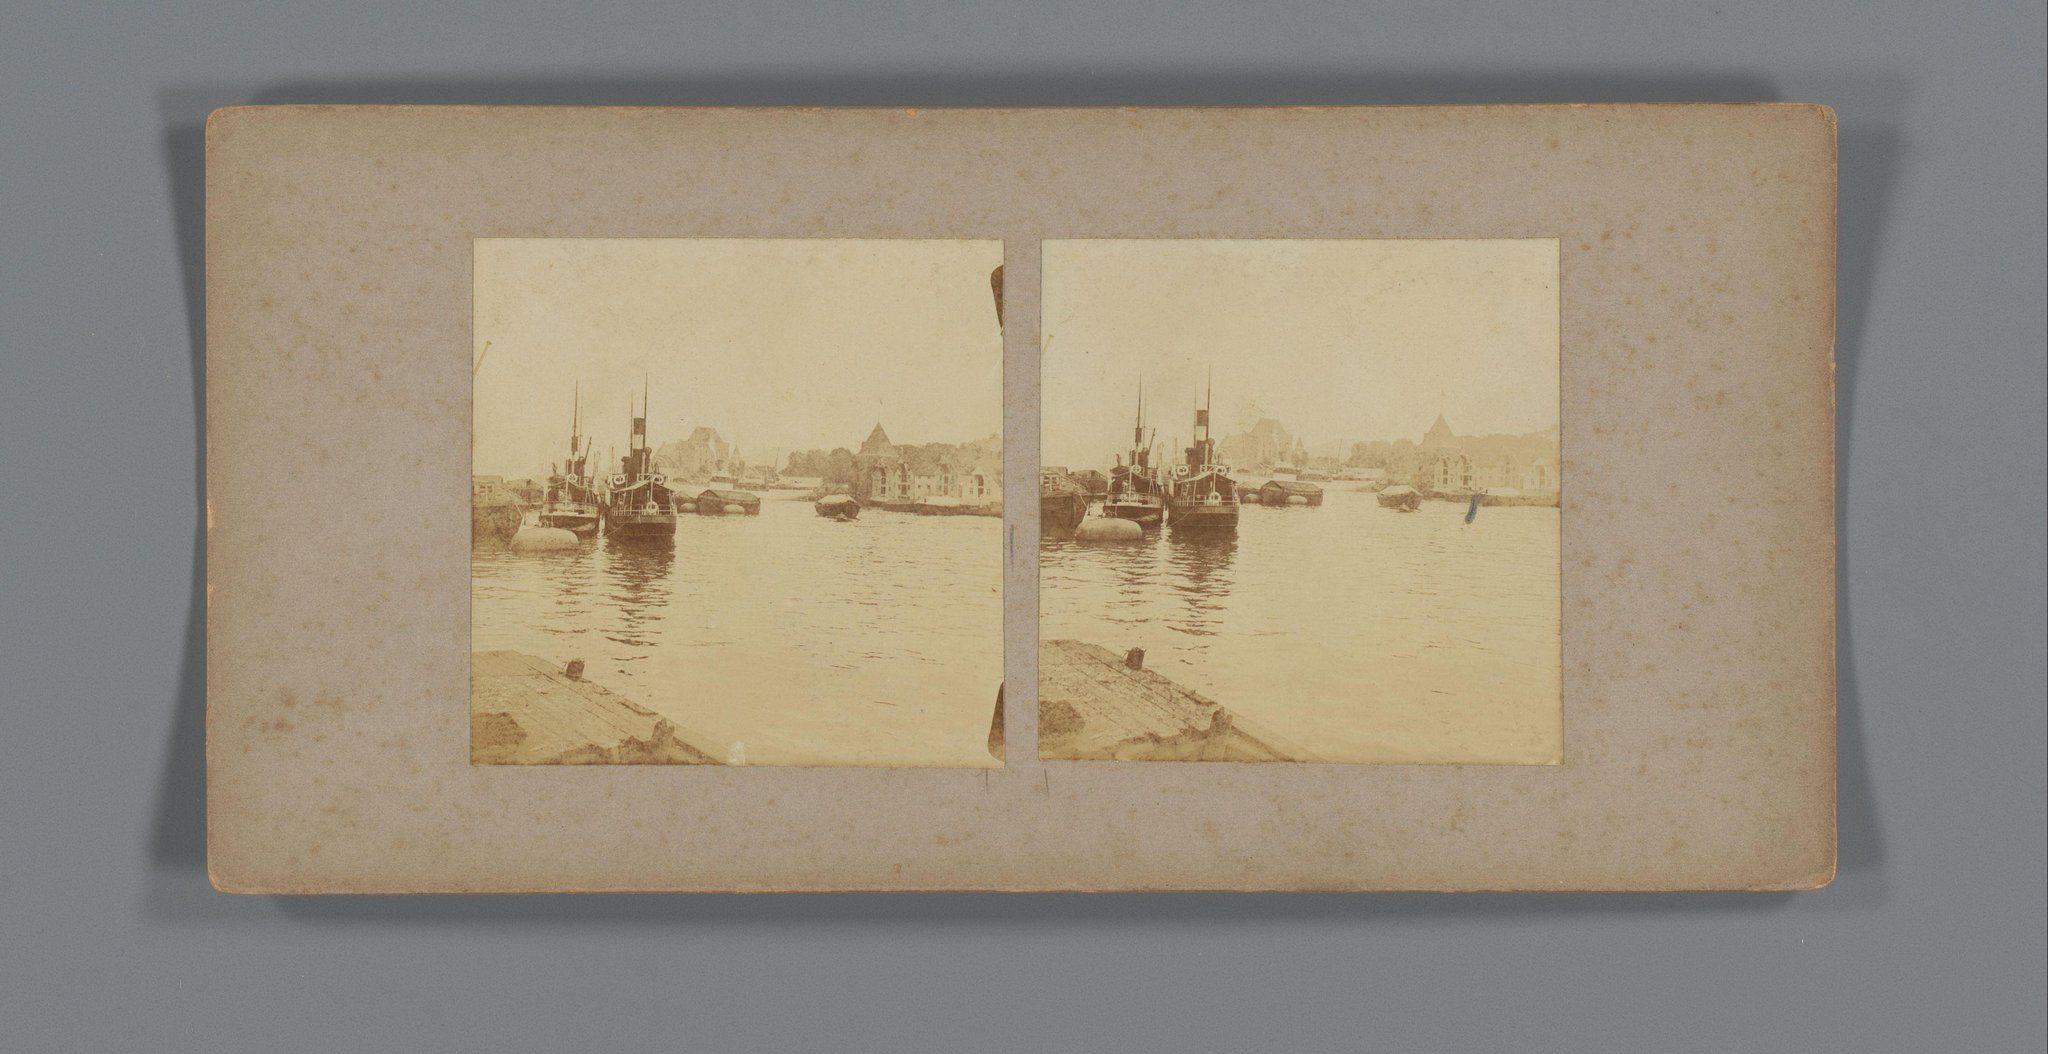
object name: stereograph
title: Bergen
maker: Anonymous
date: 1882-1890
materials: cardboard, photographic support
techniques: gelatin silver print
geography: bergen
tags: harbour